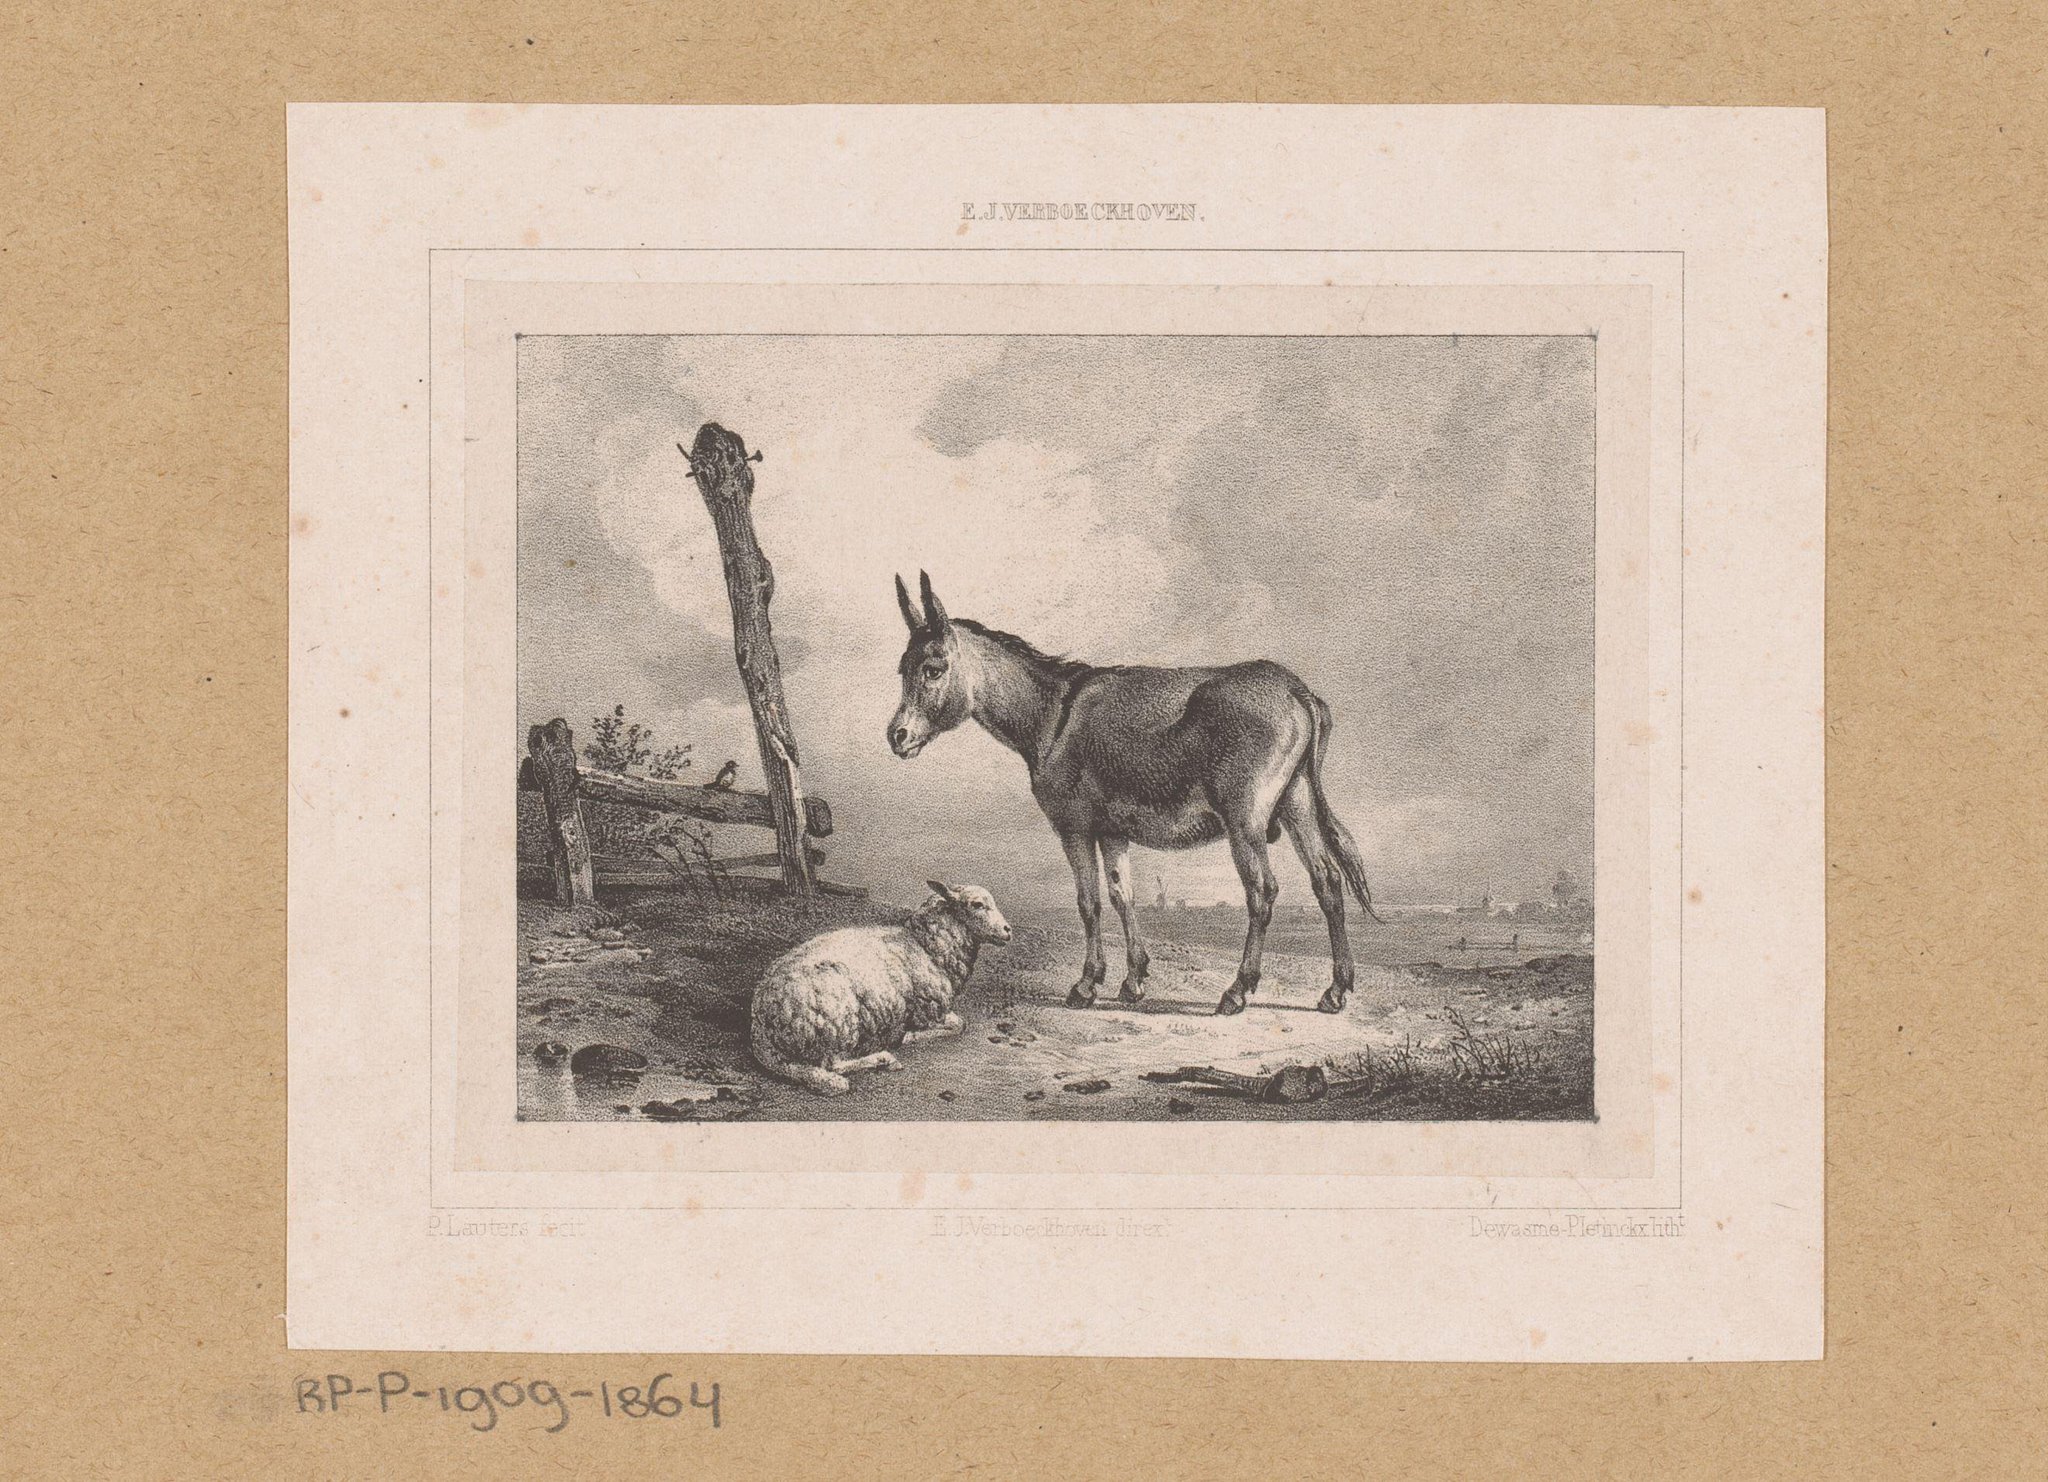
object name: print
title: Album lithographié par Paul Lauters d'après les dessins des principaux peintres du Royaume des Pays-Bas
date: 1829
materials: paper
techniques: lithograph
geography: brussels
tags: ass, donkey, sheep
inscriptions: collector's mark: Lugt 2228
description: Prent verschenen in: Verboeckhoven, Eugène. Album lithographié par Paul Lauters d'après les dessins des principaux peintres du Royaume des Pays-Bas. Brussel: Antoine Dewasme-Pletinckx, 1829.